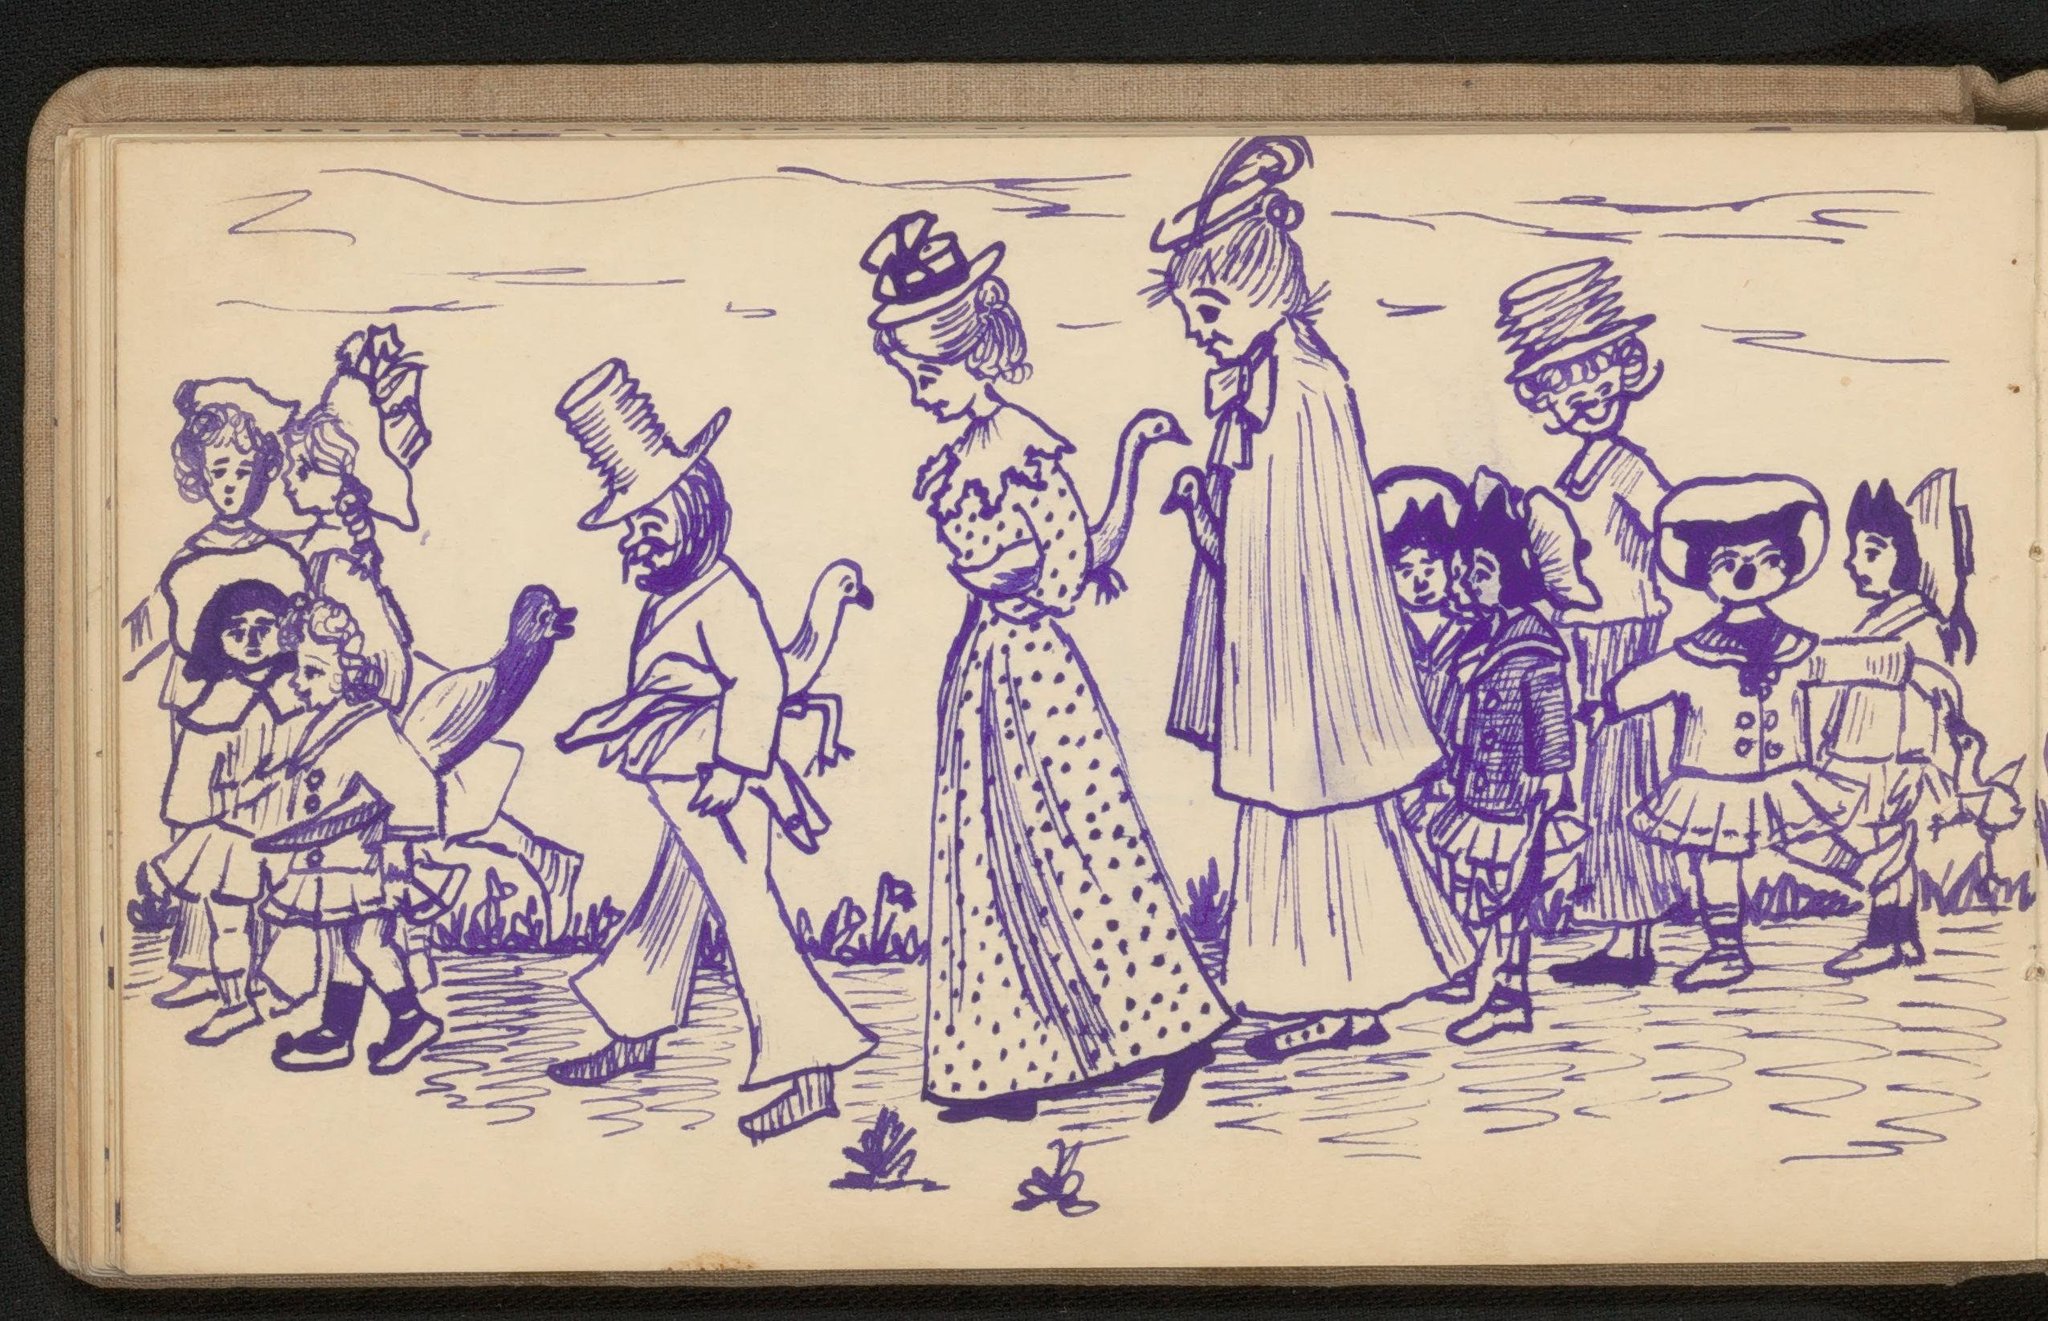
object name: sketchbook leaf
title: Na de tentoonstelling van pluimvee naar huis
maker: Anonymous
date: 1875-1920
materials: ink, paper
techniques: pen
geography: netherlands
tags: birds, fowl (cock, hen, chicken, etc.), collection, exhibition, show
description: De familie keert terug naar huis met vogels onder de arm, na het bezoek aan de 'Tentoonstelling van Pluimgedierte'. Onderdeel van het schetsboek met humoristische tekeningen over het leven van een 'famille nombreuse'. Onderwerpsrubrieken binnen de Atlas Zeden en Gewoonten: Zeden en Gewoonten in Engeren Zin, Des menschen beging, midden en einde, Kinderleven.